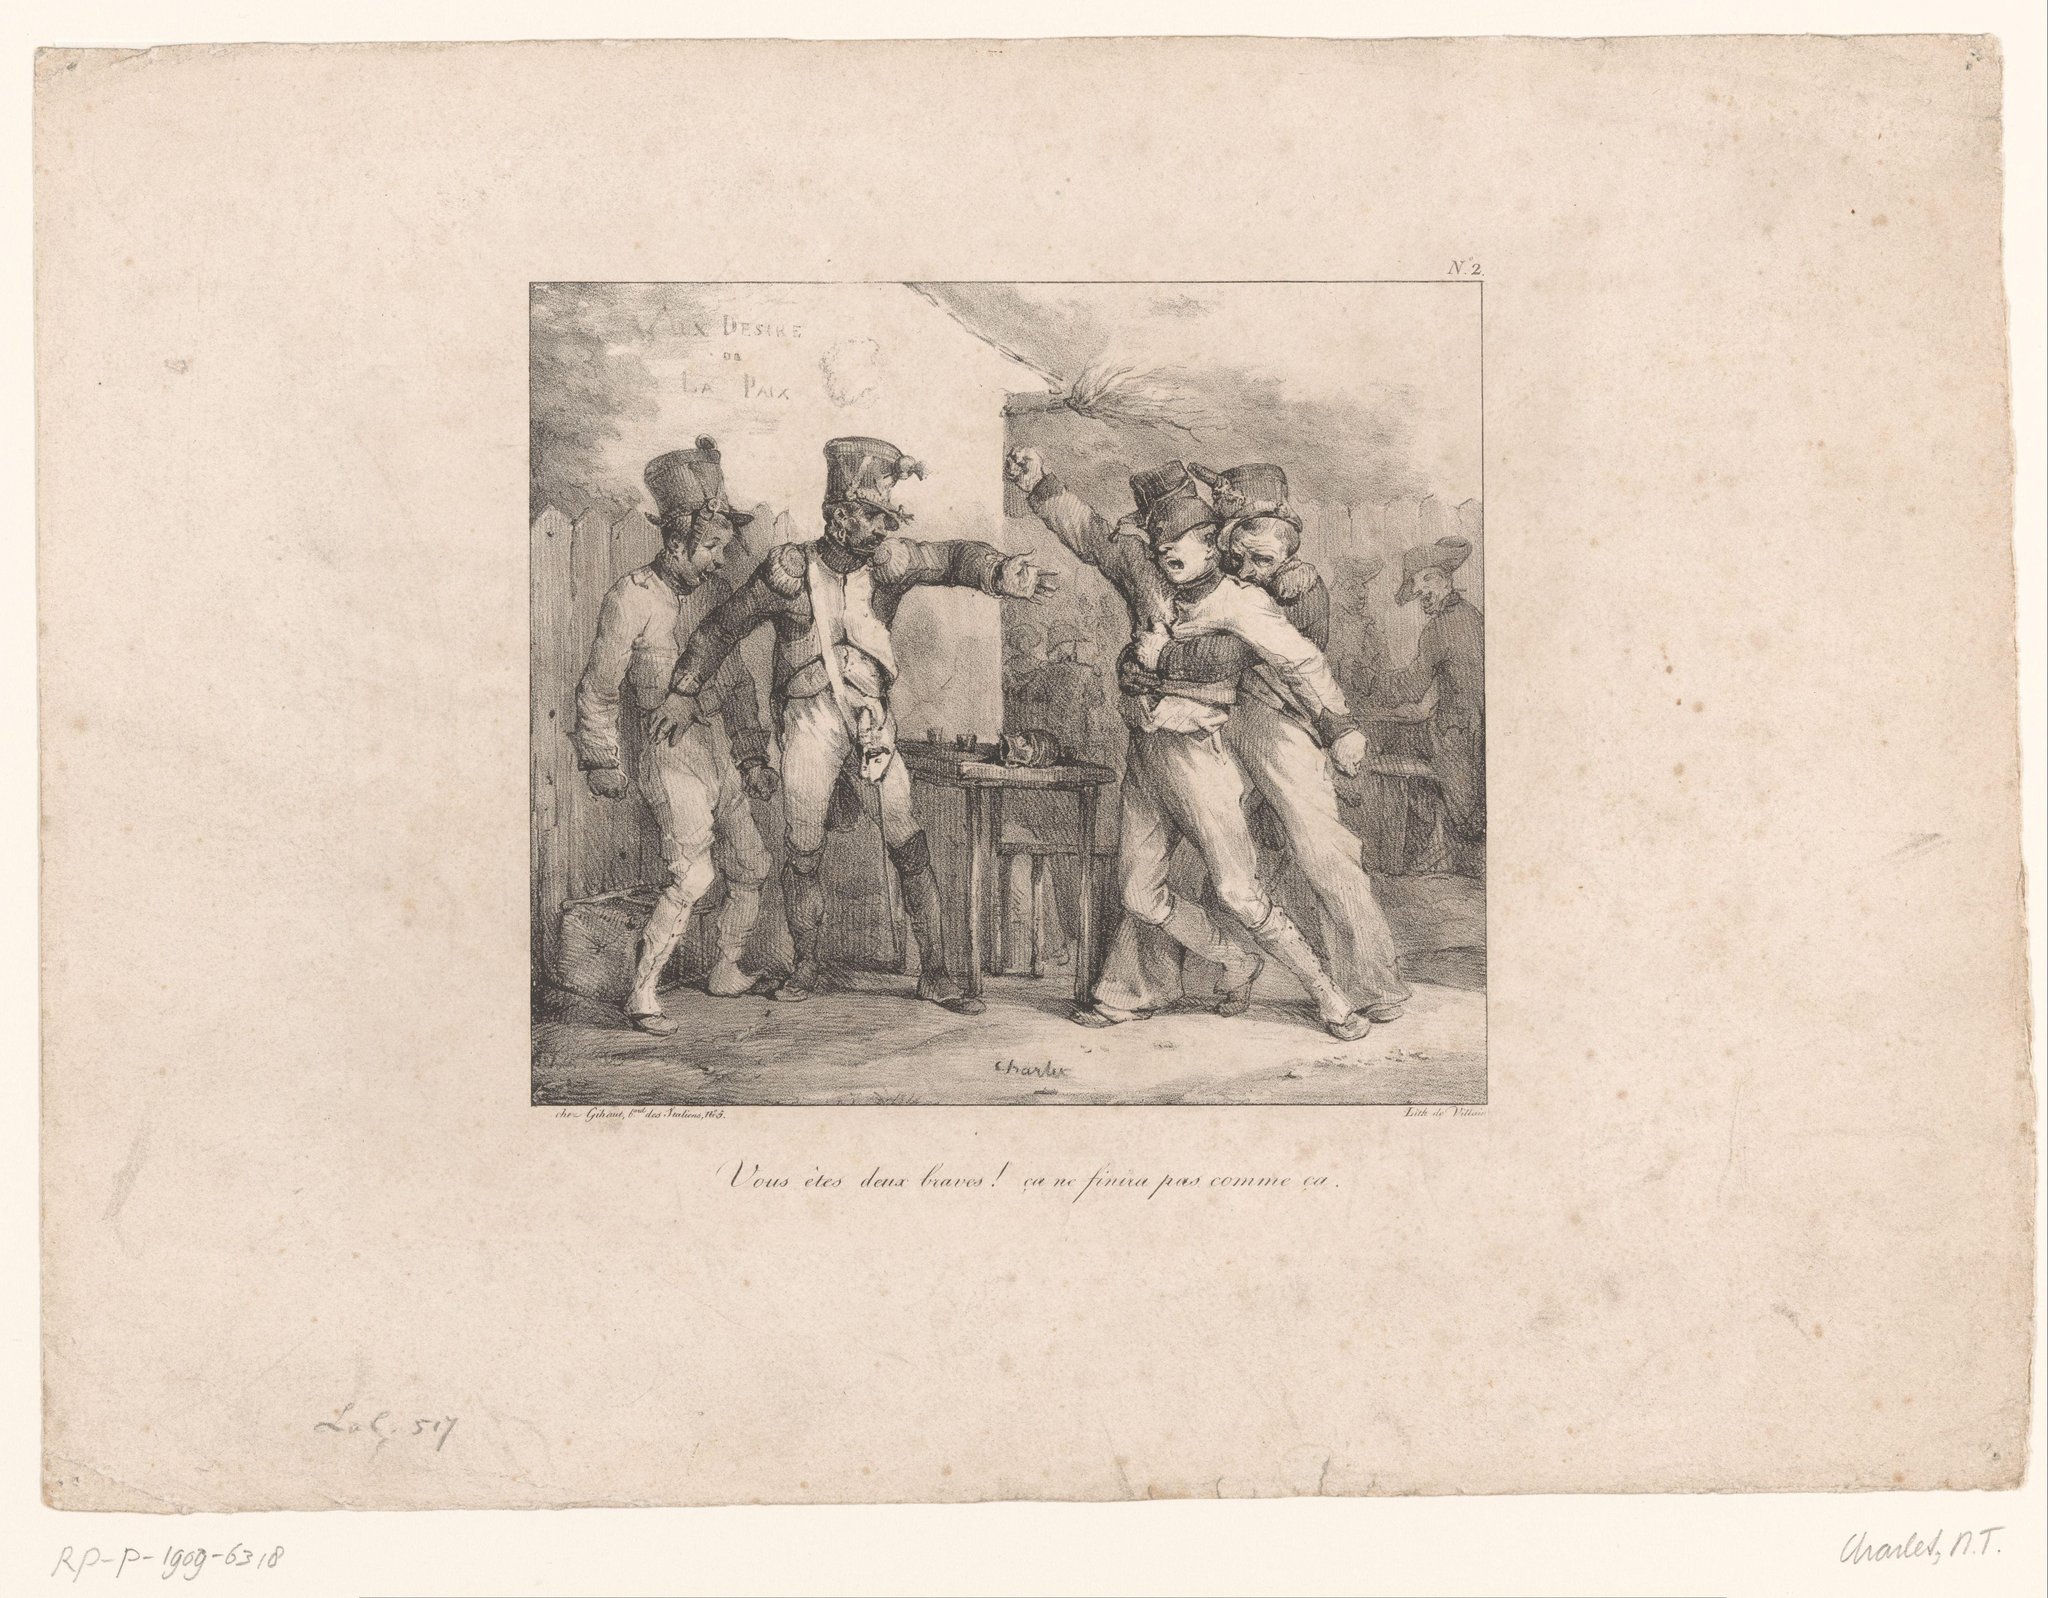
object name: print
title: Vous êtes deux braves! ça ne finira fras comme ça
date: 1823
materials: paper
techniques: lithograph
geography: paris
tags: canteen ~ the soldier off duty, fist-fight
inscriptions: collector's mark: Lugt 2228a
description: Achter de vechtende soldaten is de muur van een kroeg te zien, waarop de ironische tekst 'in het verlangen naar vrede' te lezen is.